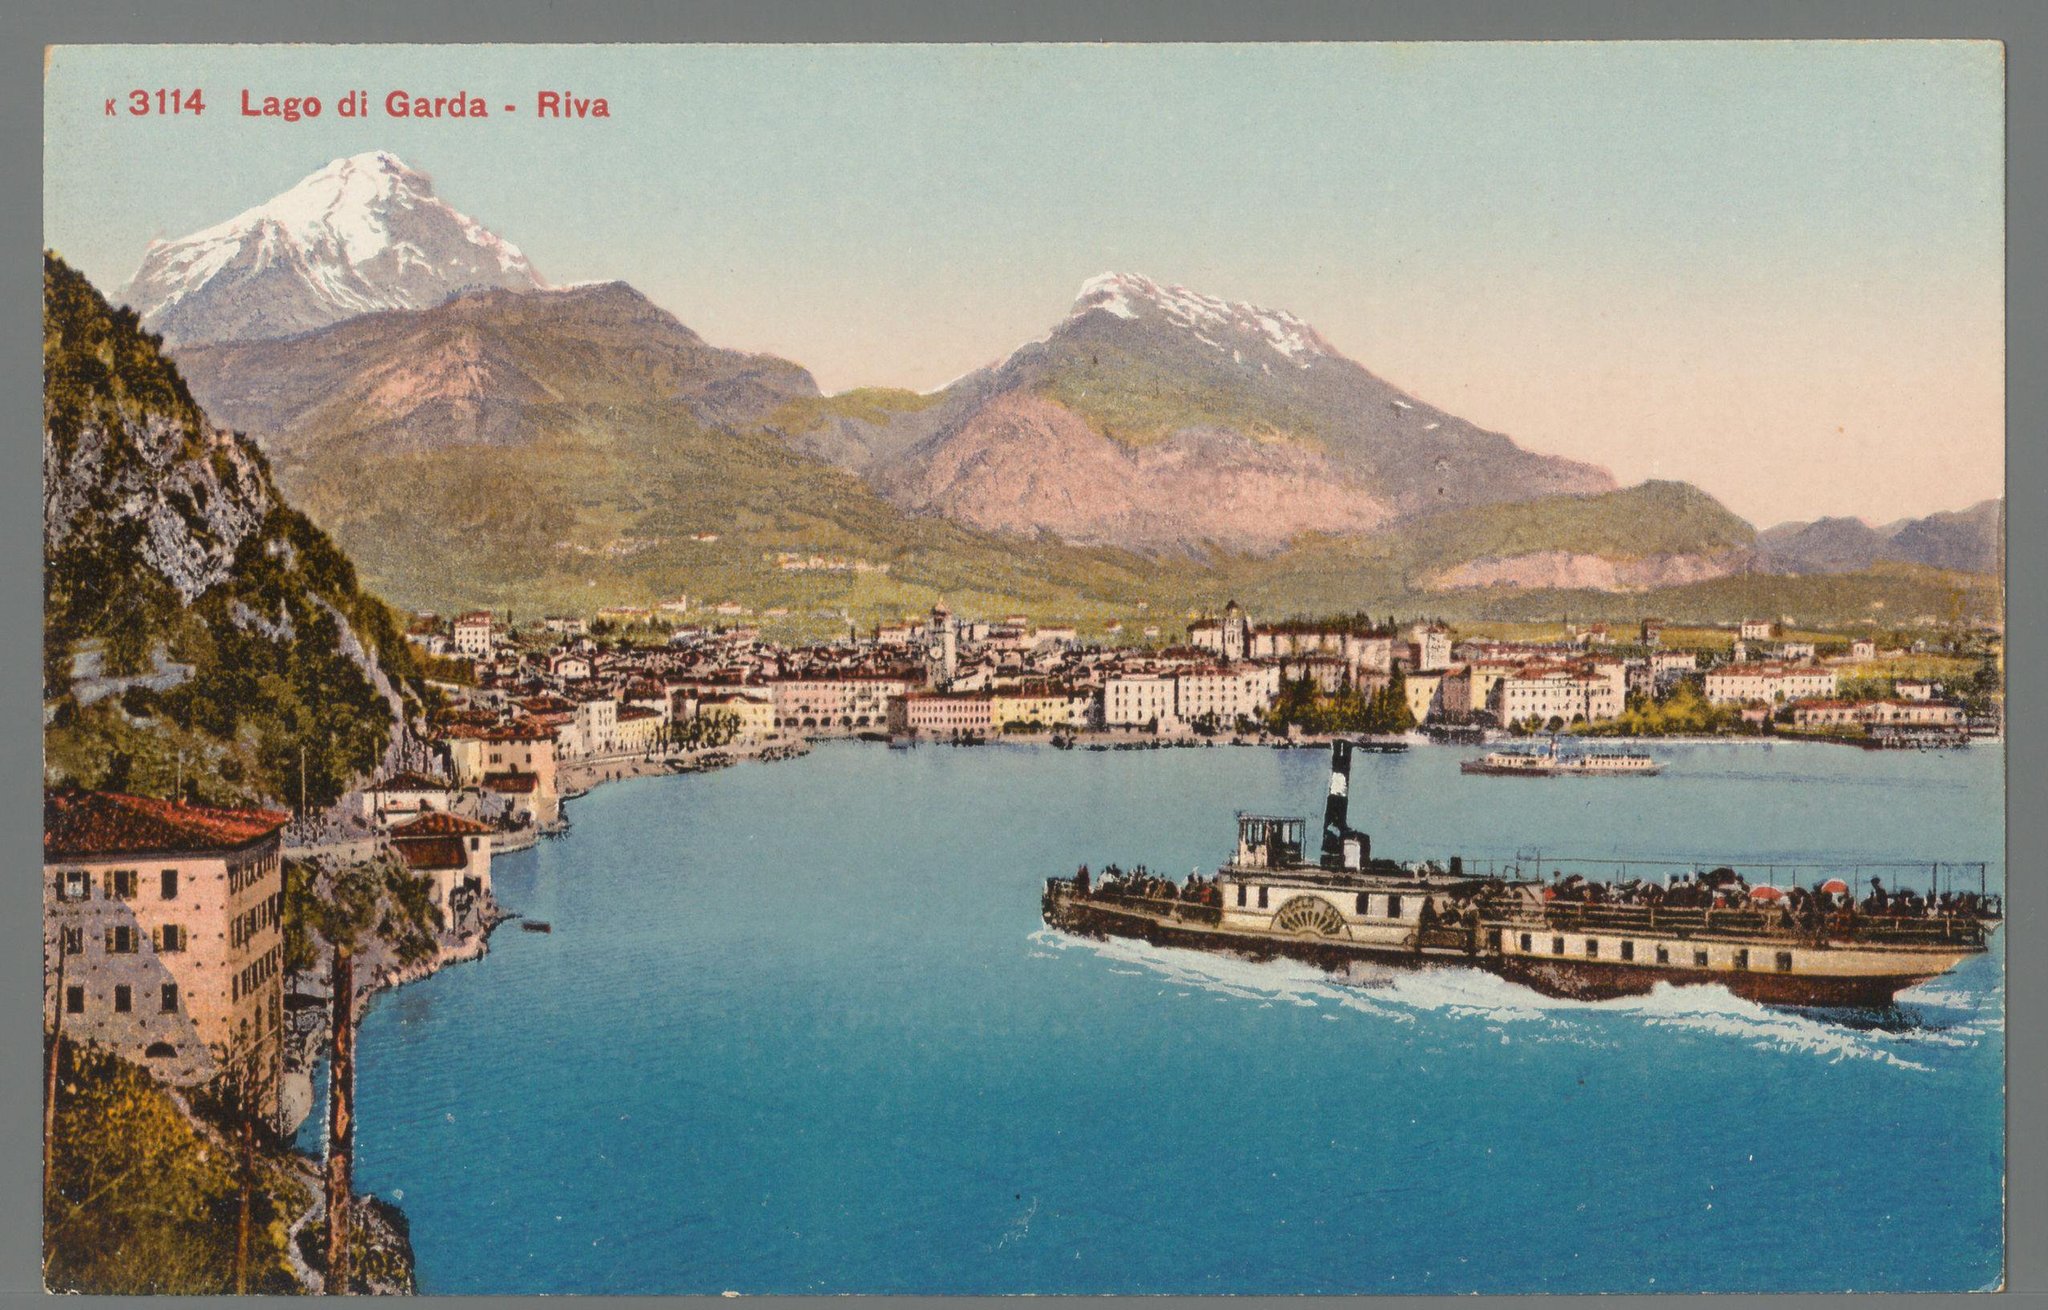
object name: ansichtkaart, prentbriefkaart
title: Lago di Garda. Riva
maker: Anonymous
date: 1905-1930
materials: cardboard, photographic process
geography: riva del garda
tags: ships (in general), lake, mountains